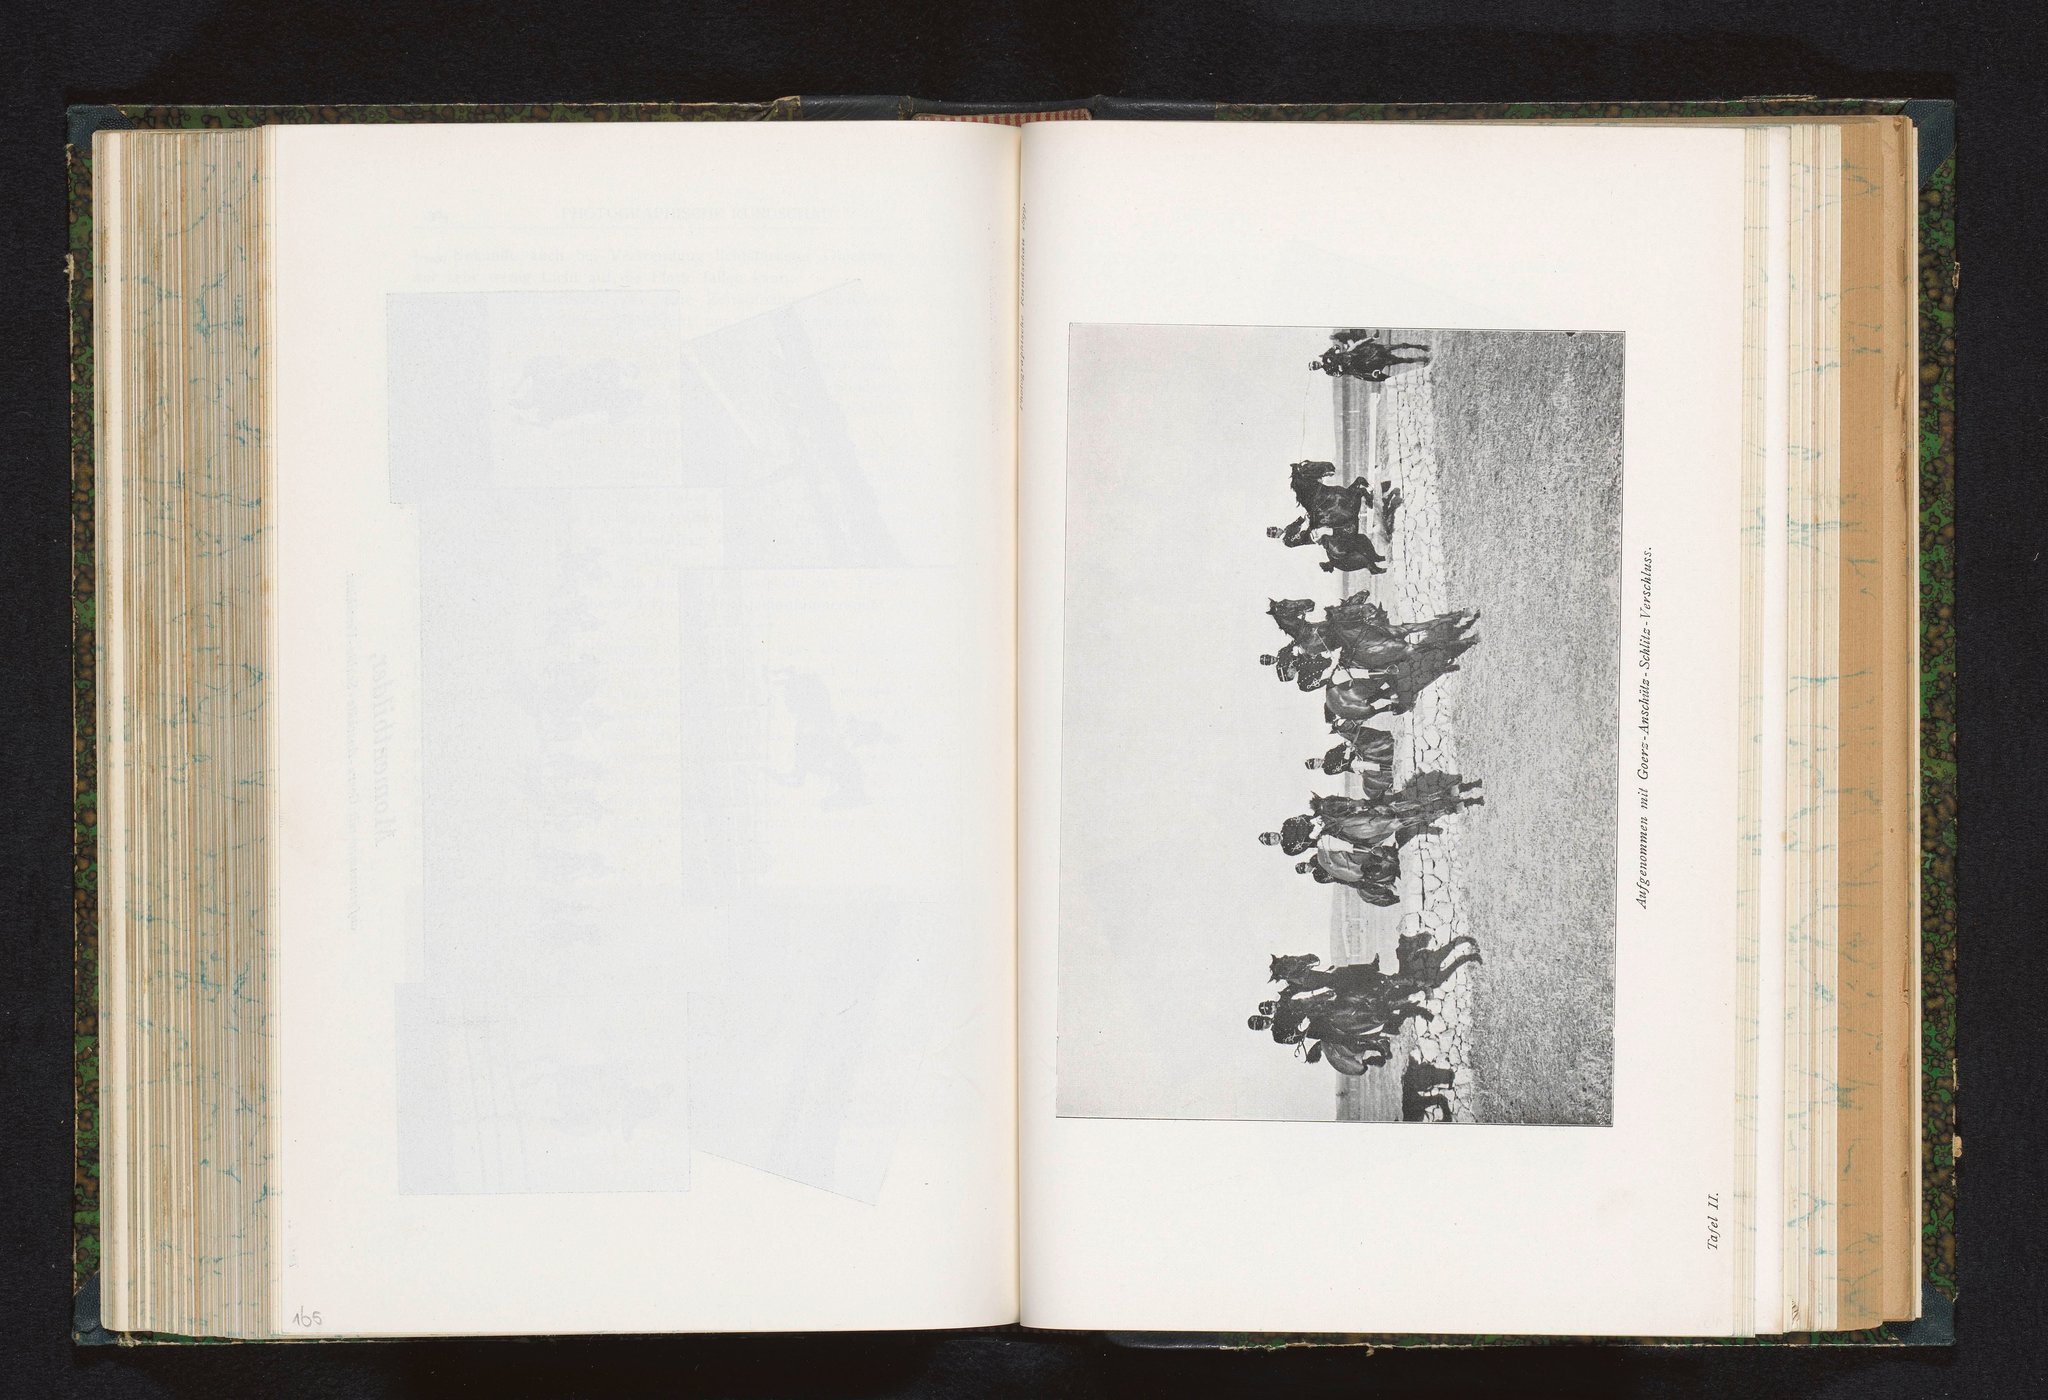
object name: page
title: Paarden met ruiters springen over een muur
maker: Anonymous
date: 1894-1899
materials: paper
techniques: autotype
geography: berlin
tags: jumping (horse in motion)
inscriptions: inscription: ‘Aufgenommen mit Goerz-Anschütz-Schlitz-Verschluss.’, inscription: ‘Tafel II.’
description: Prent op tweede ongenummerde pagina na pagina 304.